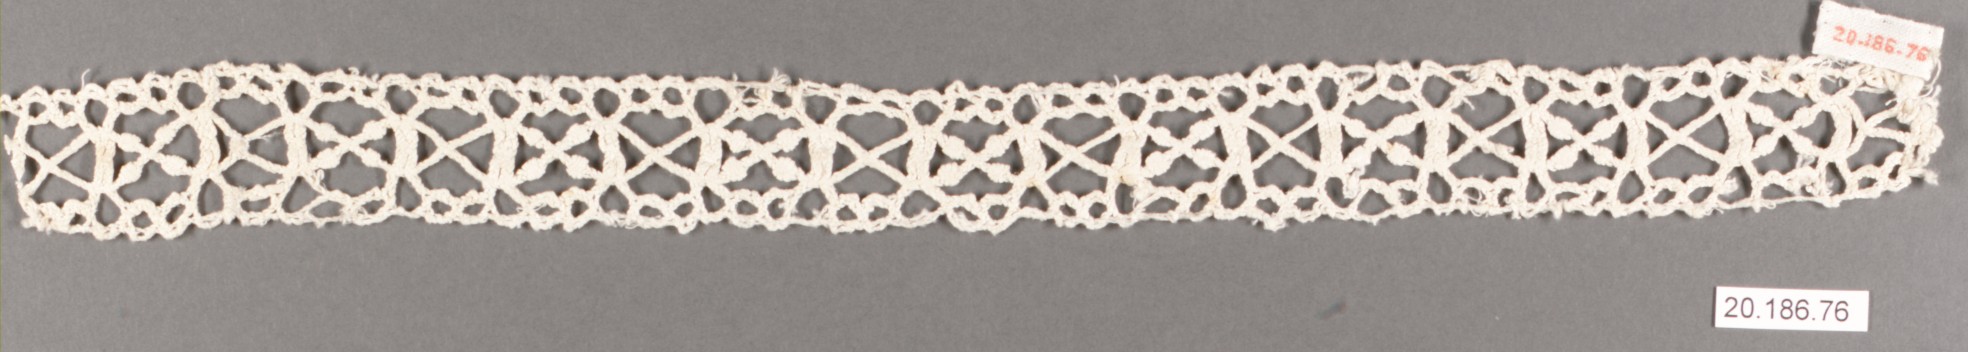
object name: insertion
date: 1501-1600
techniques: lace